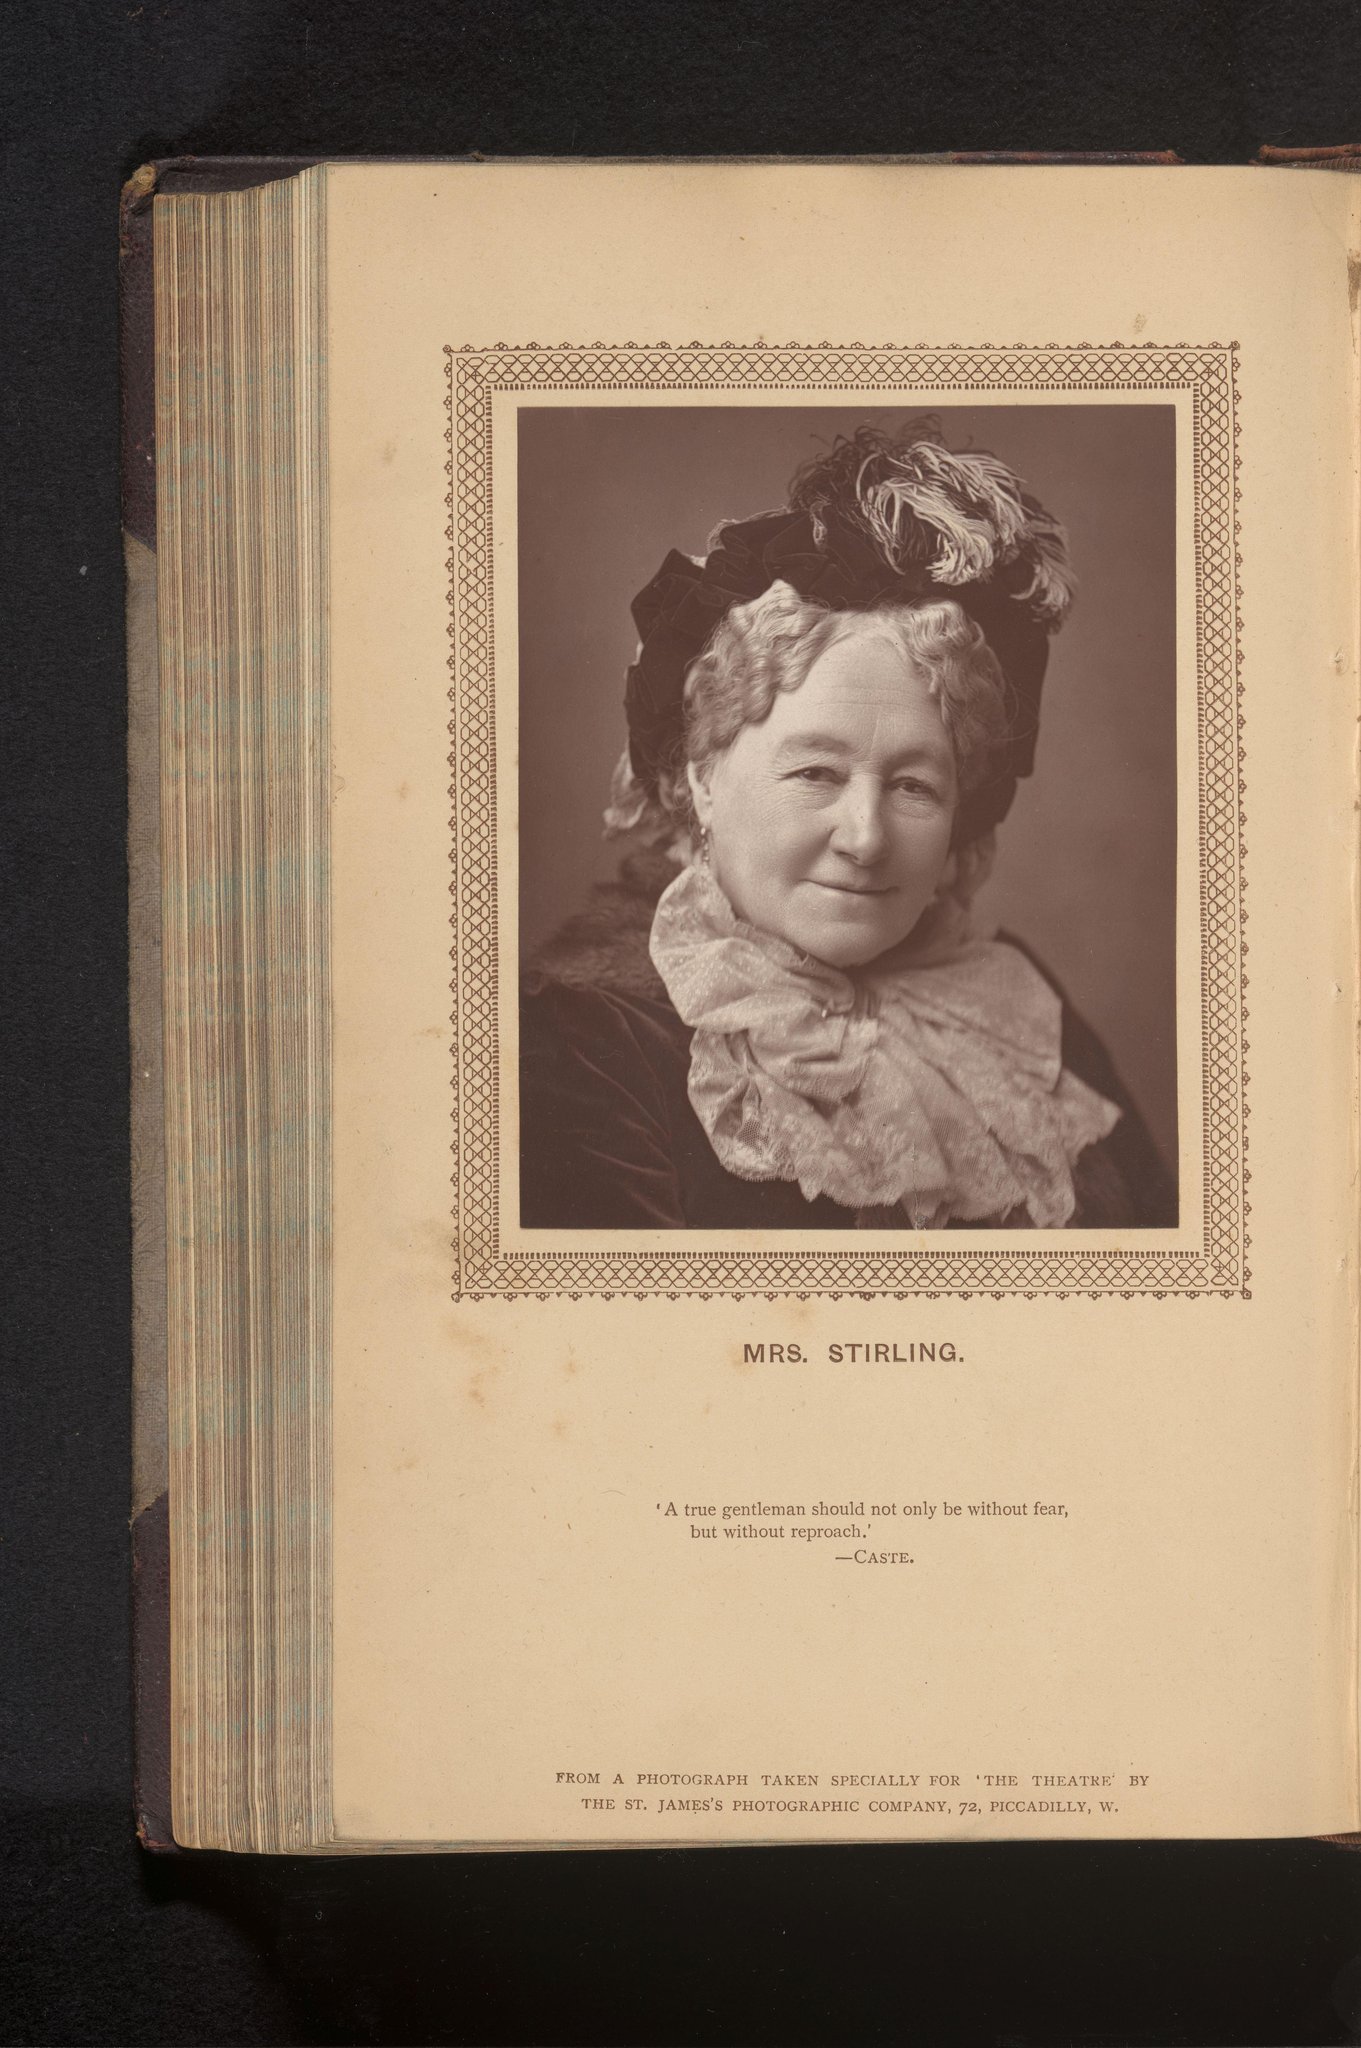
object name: photomechanical print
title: Portret van Mary Anne Stirling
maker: Anonymous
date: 1878-1883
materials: paper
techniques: woodburytype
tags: adult woman, historical persons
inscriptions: inscription: ‘'A true gentleman should not only be without fear,/ but without reproach.'/ - Castle’